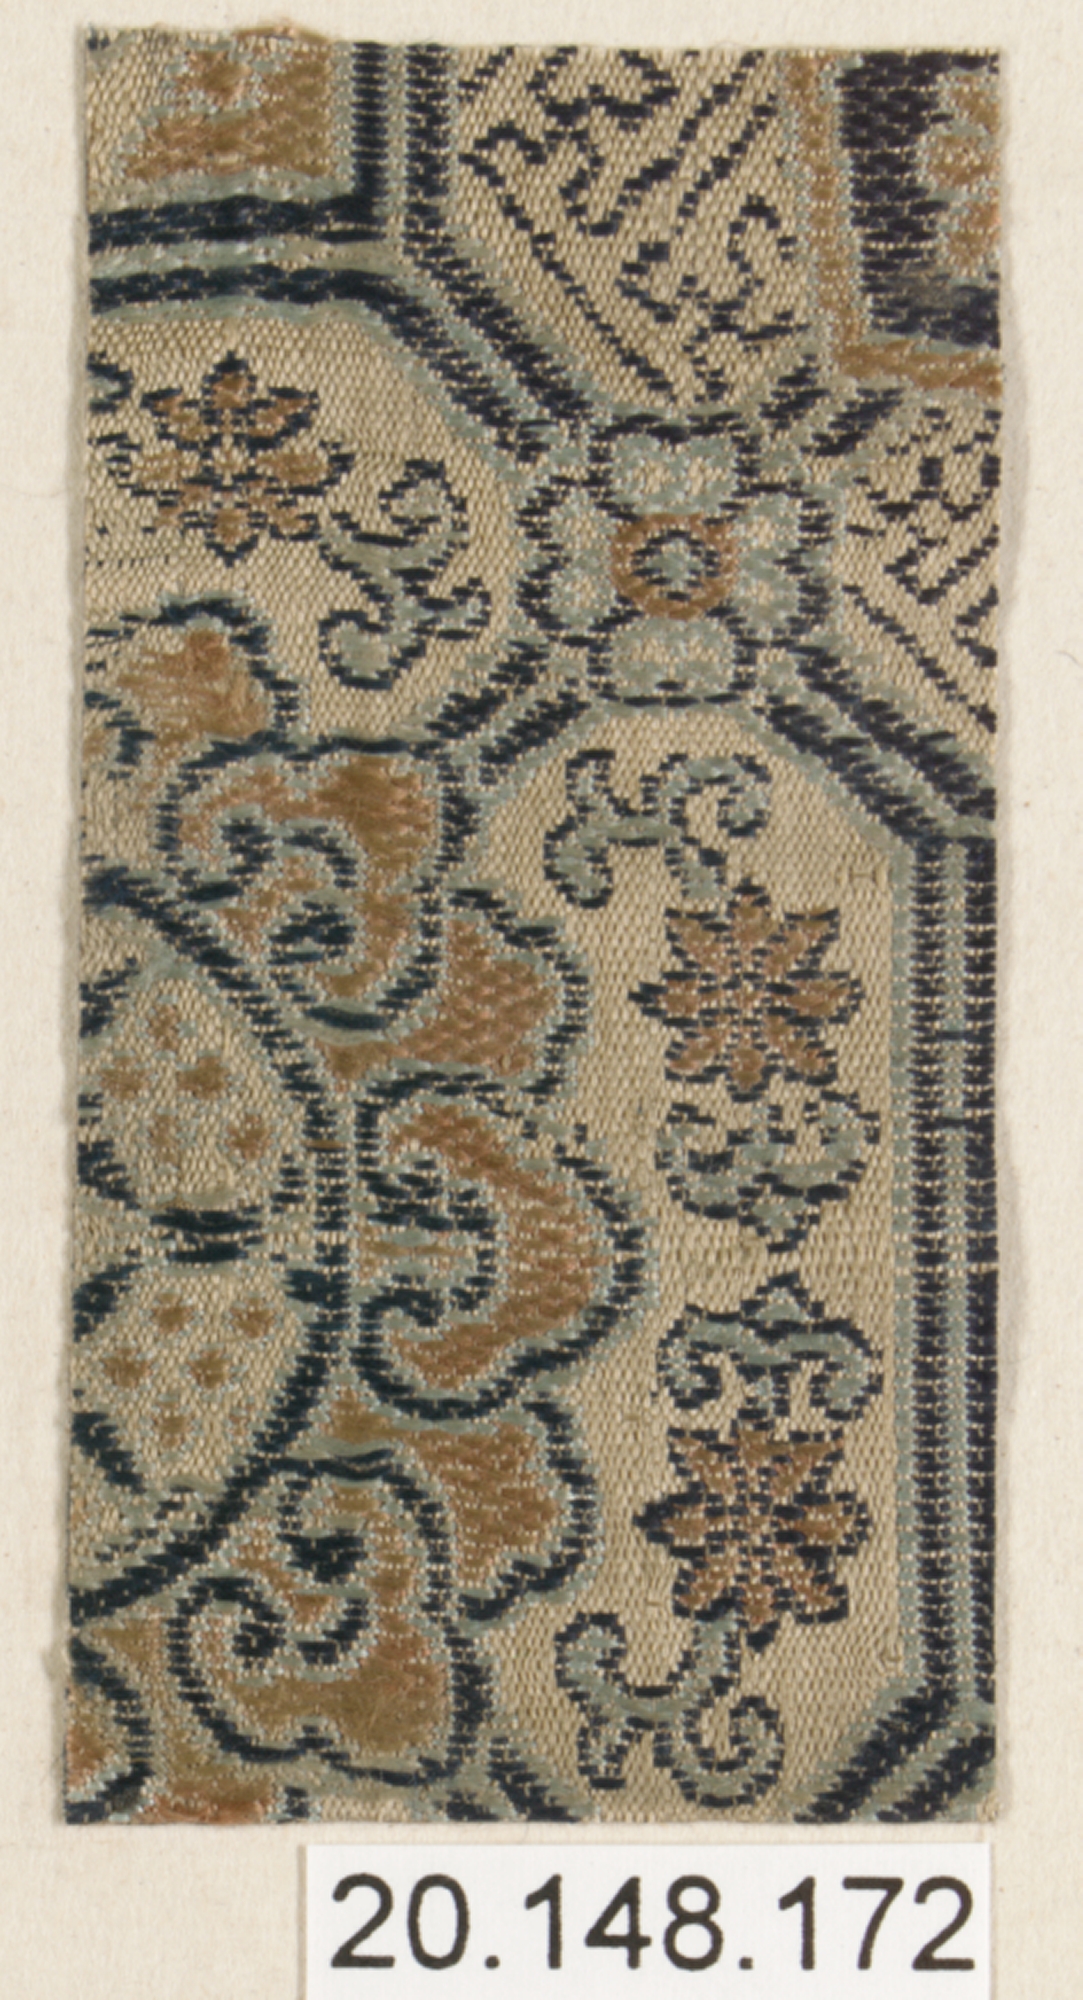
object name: piece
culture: japanese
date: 1701-1800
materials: silk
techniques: compound weave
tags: flowers